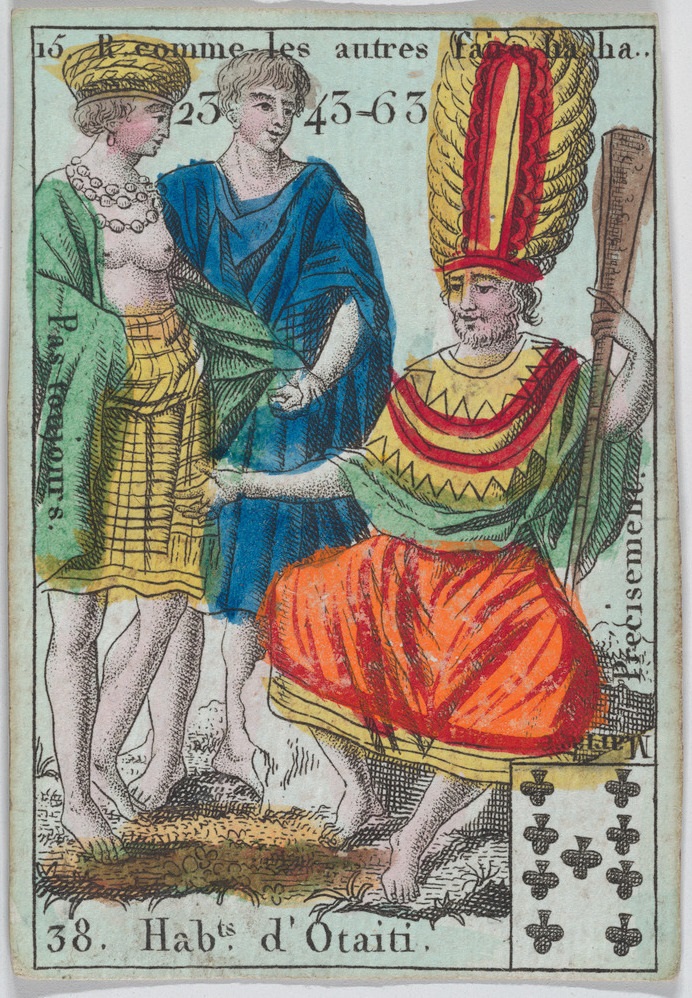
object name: print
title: Hab.ts d'Otaiti from playing cards "Jeu d'Or"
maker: anonymous, french, 18th century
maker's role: artist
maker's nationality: french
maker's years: 1700-1800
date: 1700-1799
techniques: etching, hand coloring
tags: men,female nudes,playing cards